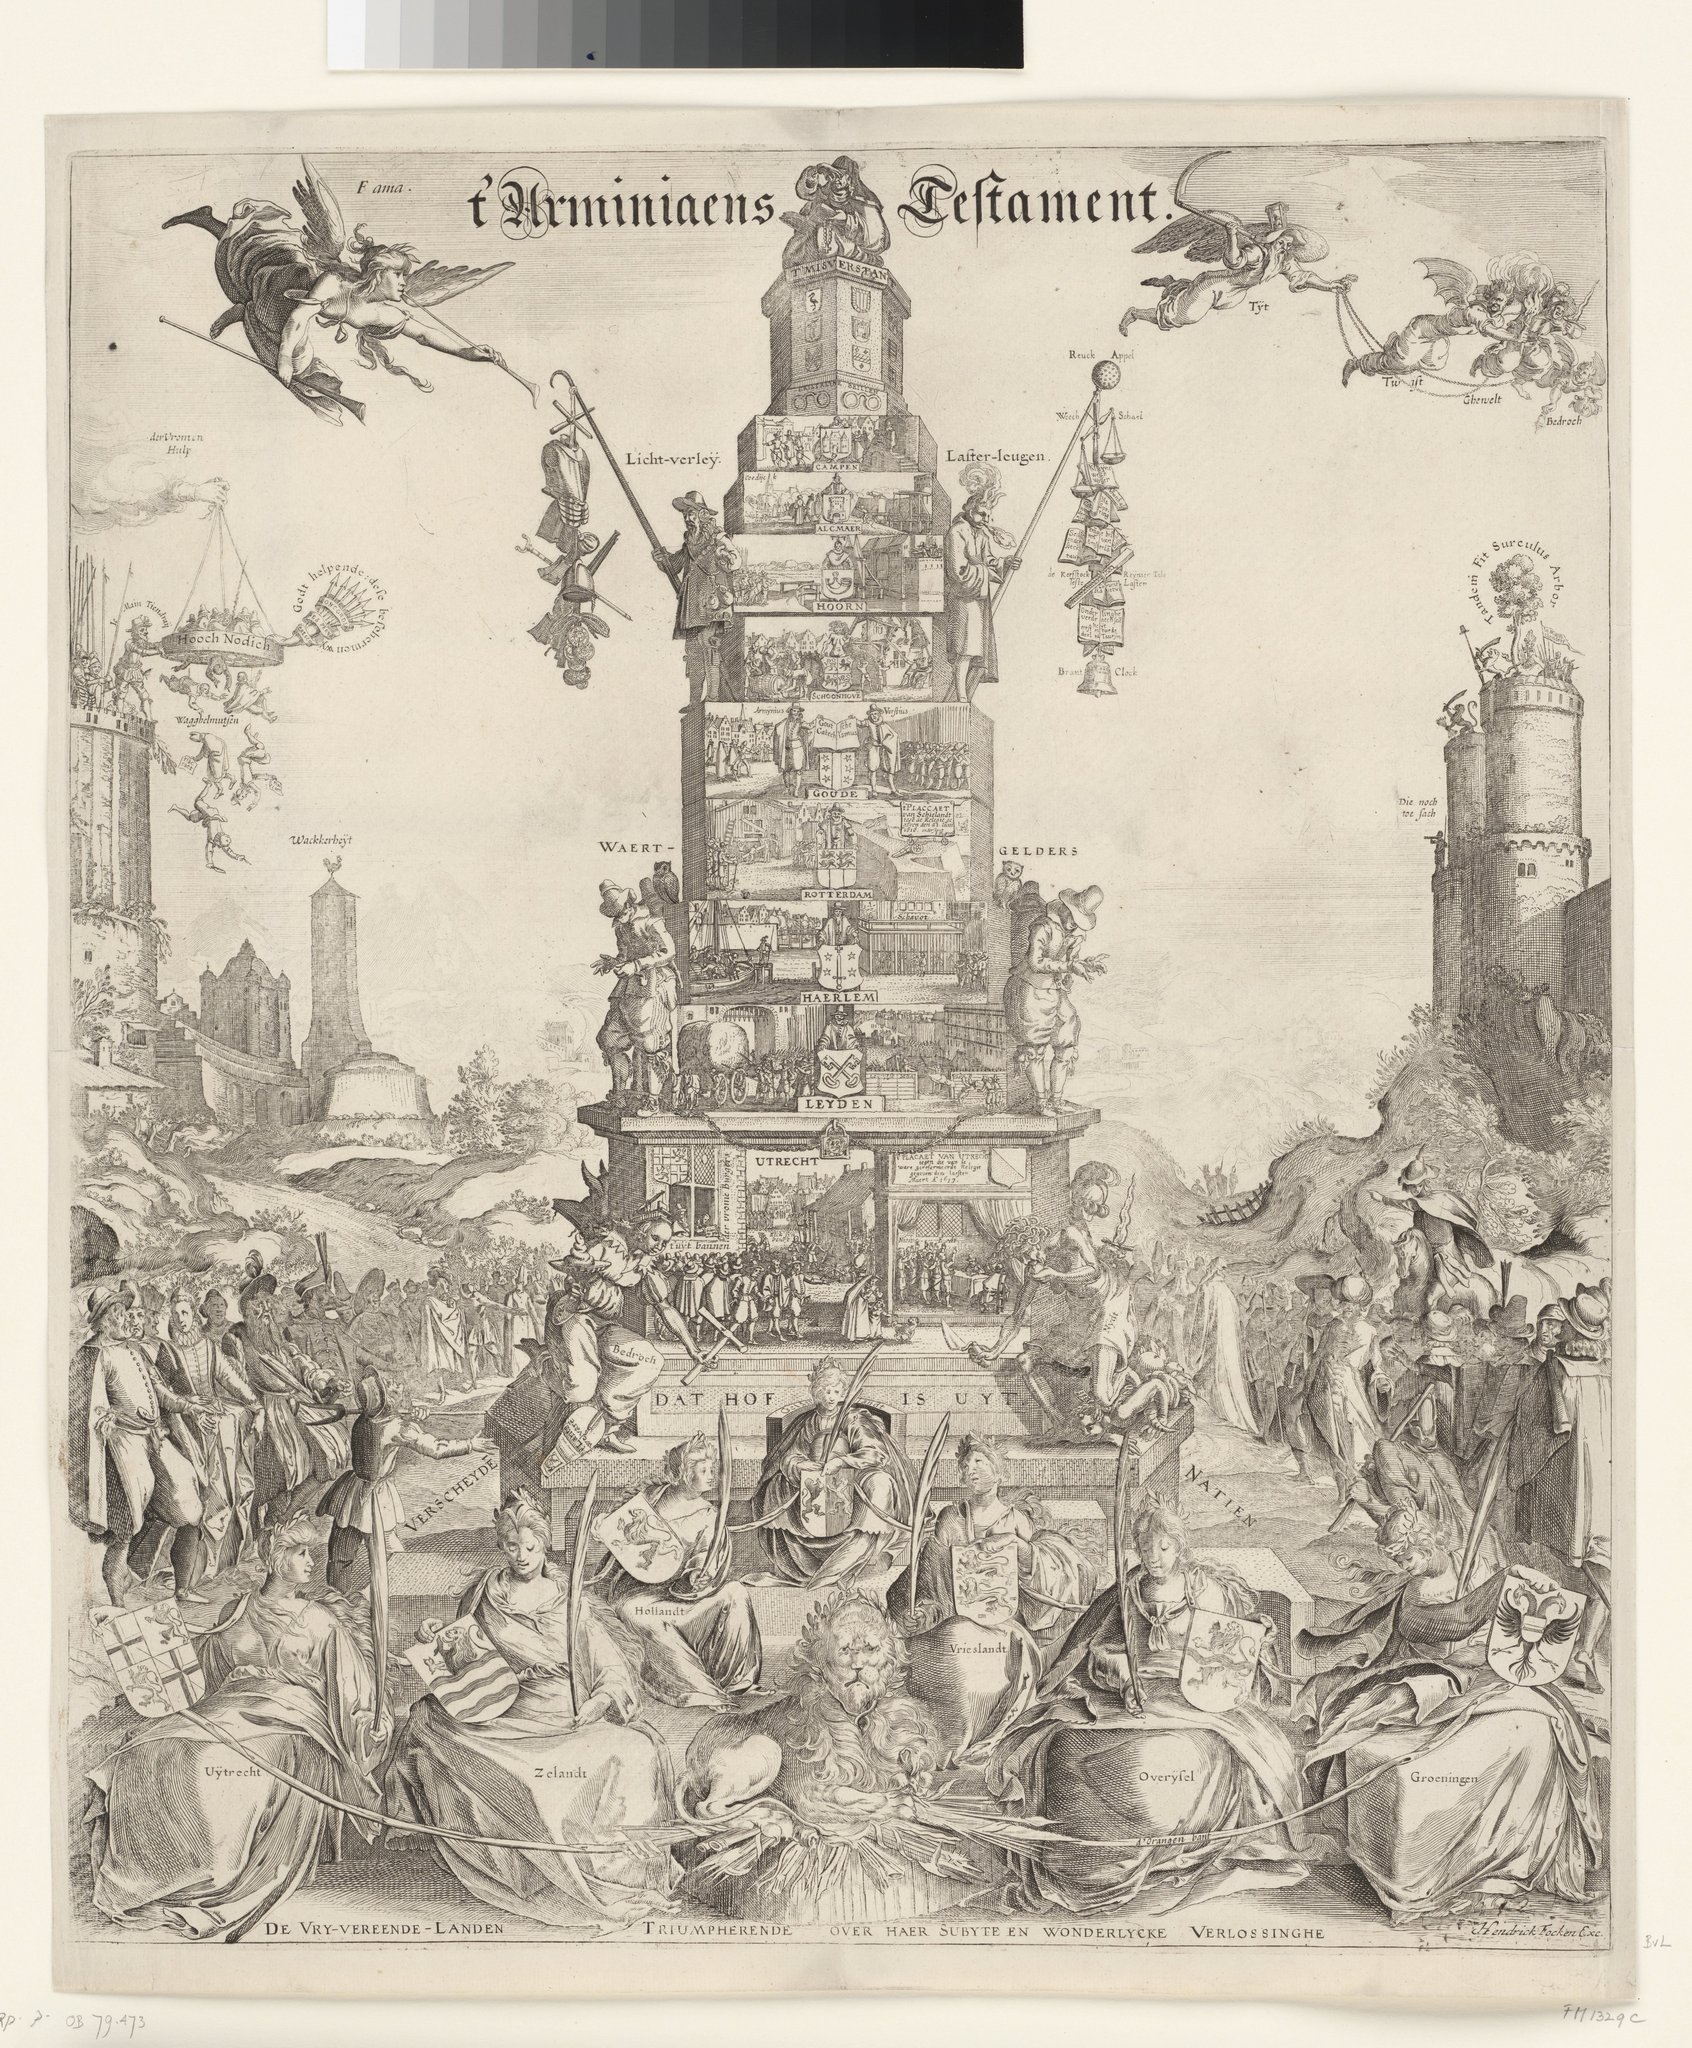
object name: print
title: Het Arminiaans Testament, 1618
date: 1609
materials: paper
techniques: engraving, etching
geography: amsterdam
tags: maurice (prince of orange), cologne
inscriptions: collector's mark: Lugt 240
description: Gedetailleerde allegorische voorstelling waarin de arminianen bespot worden. De prent is een bewerking van een oude plaat van Simon Frisius vervaardigd in 1609 ter gelegenheid van het Bestand. Centraal in de voorstelling staat een toren met kleine scènes van de verrichtingen van de arminianen in de steden van Utrecht, Leiden, Haarlem, Rotterdam, Gouda, Schoonhoven, Hoorn, Alkmaar en Kampen. Op de toren staan de waardgelders en personificaties van Afgunst, Bedrog, Laster, Verleiding en Dwaling. Op de voorgrond, aan de voet van de toren, zitten de zeven provinciemaagden. Links en rechts torens van de prins van Oranje en de Nederlandse Leeuw. In de lucht vliegen Faam en Tijd.